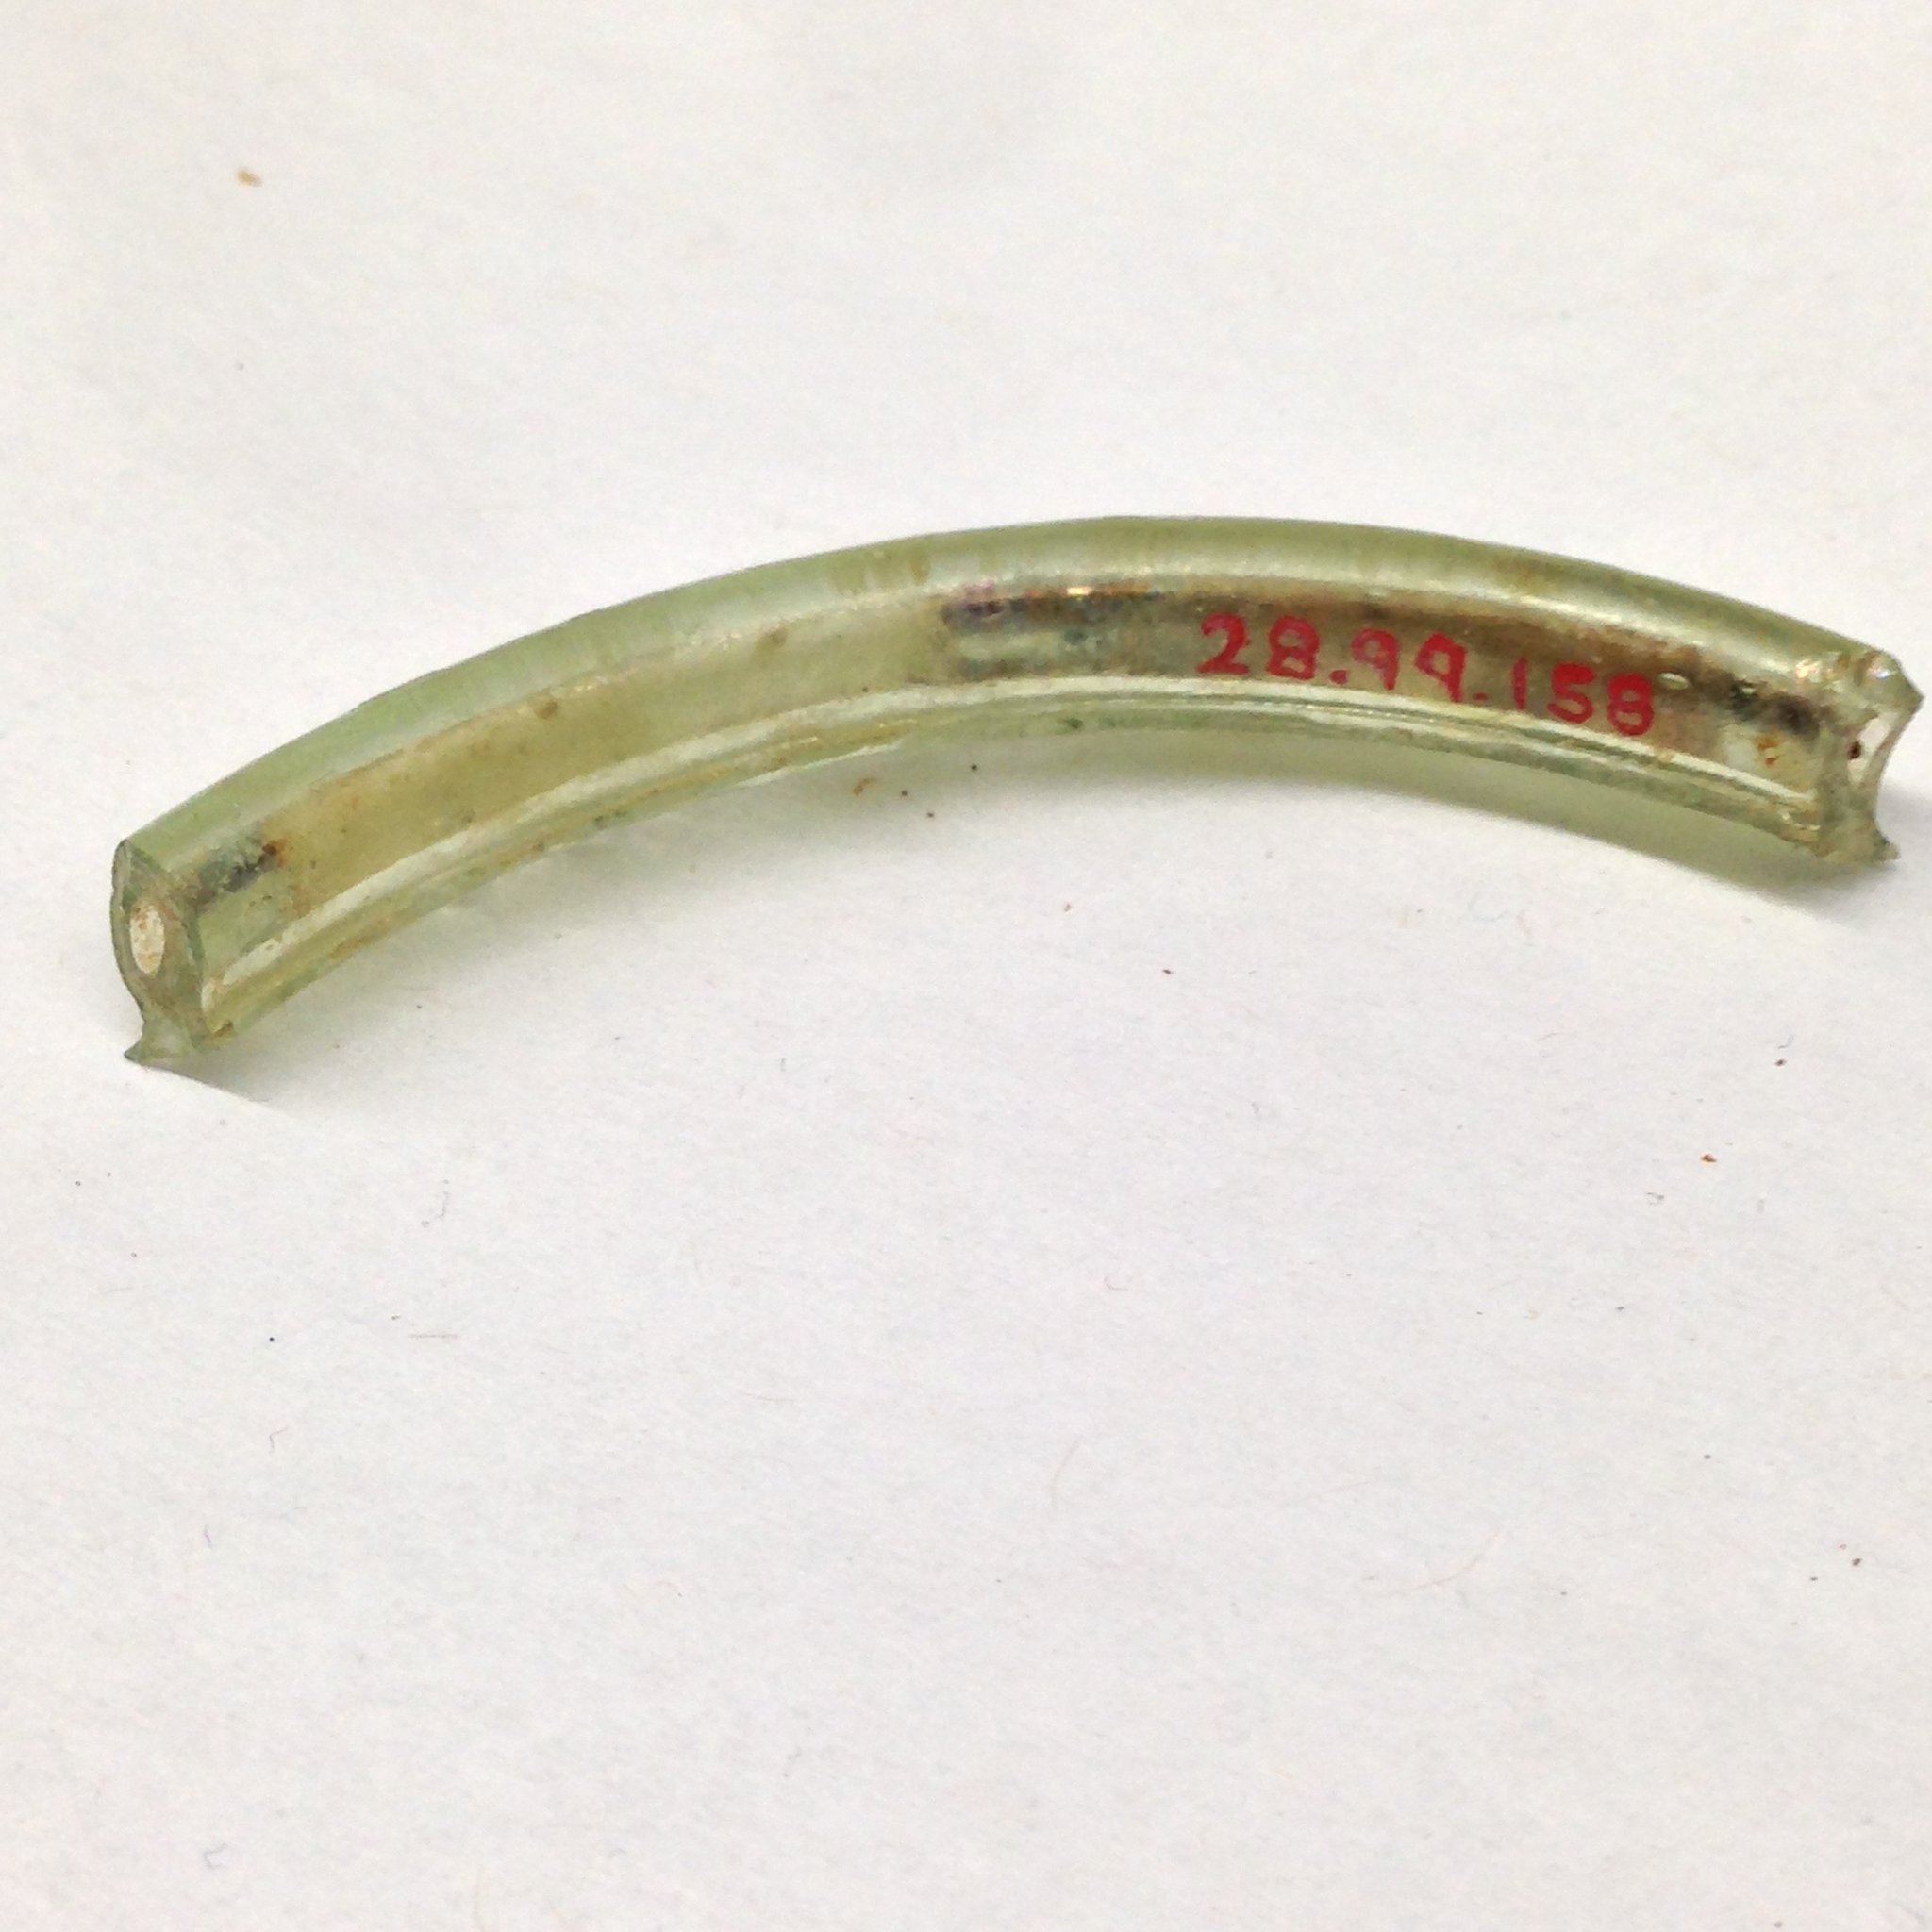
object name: fragment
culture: european or middle eastern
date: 1150-1250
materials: ceramic, glass